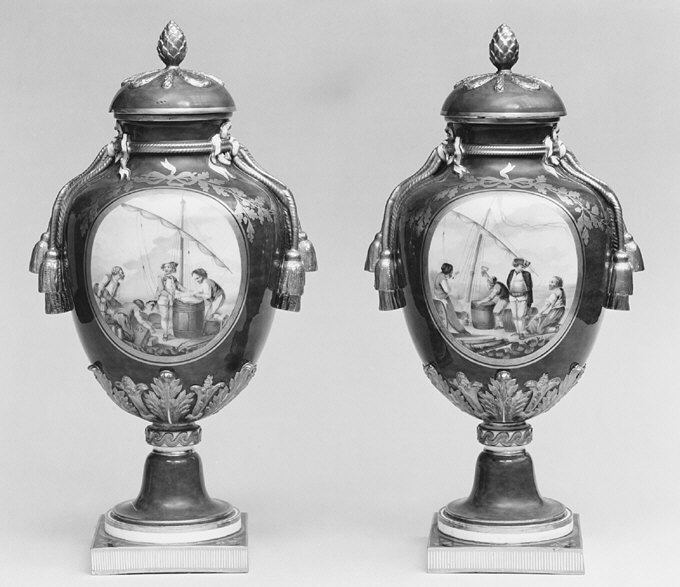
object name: vase with cover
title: Vase with cover (Vase à gland) (one of a pair)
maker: sèvres manufactory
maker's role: manufactory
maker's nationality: french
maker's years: 1740-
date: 1775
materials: soft paste porcelain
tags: men,women